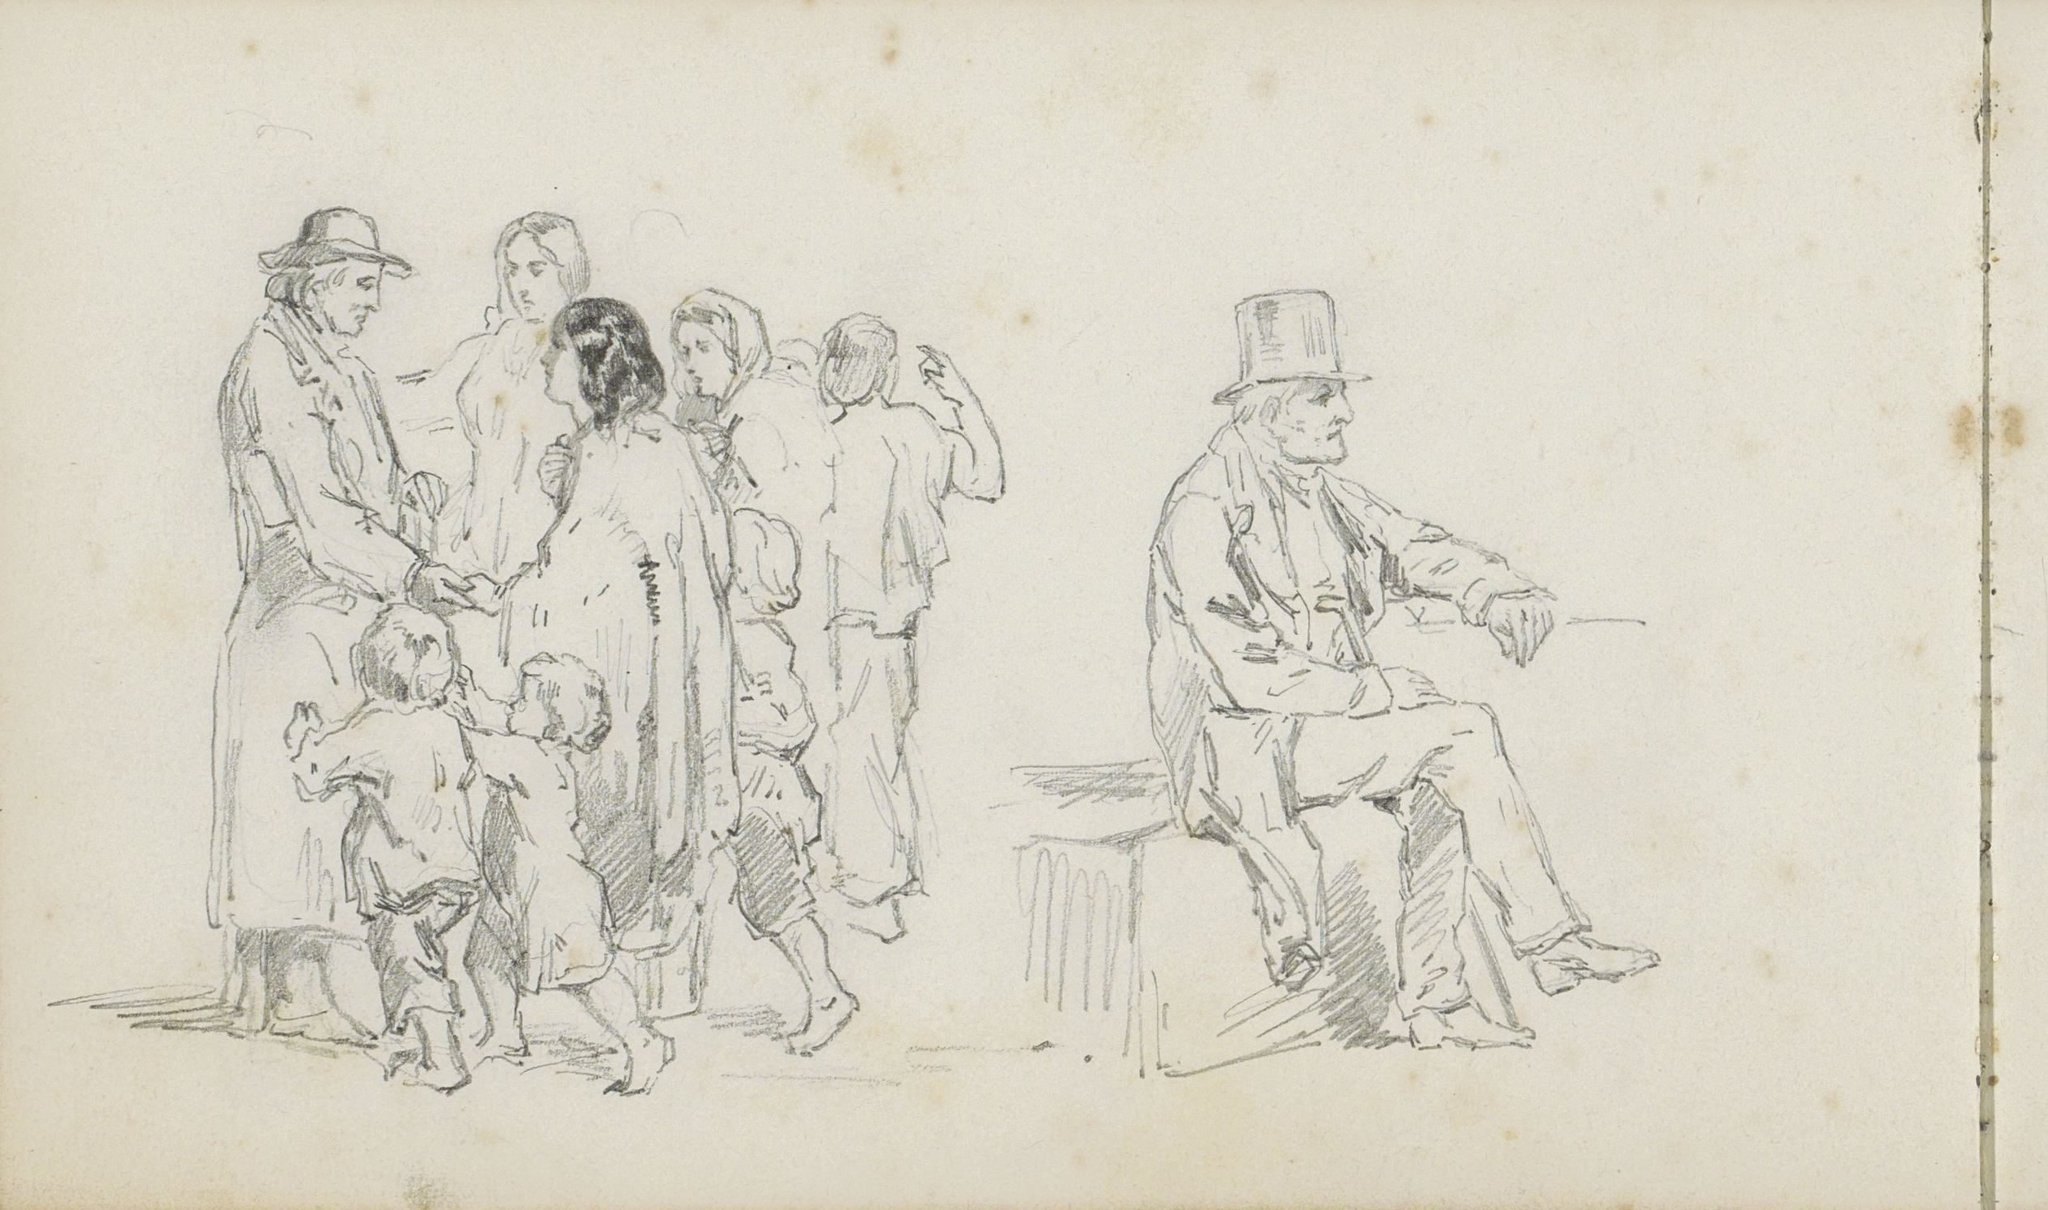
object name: sketchbook leaf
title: Man die geld geeft aan een groep bedelaars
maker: charles rochussen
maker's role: draughtsman, painter, print maker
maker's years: 1814-1894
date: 1840-1860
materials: paper, pencil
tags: sitting figure, walking-stick, staff, beggar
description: Tevens een studie van een zittende man met een wandelstok. Blad 22 verso uit een schetsboek met 38 bladen.